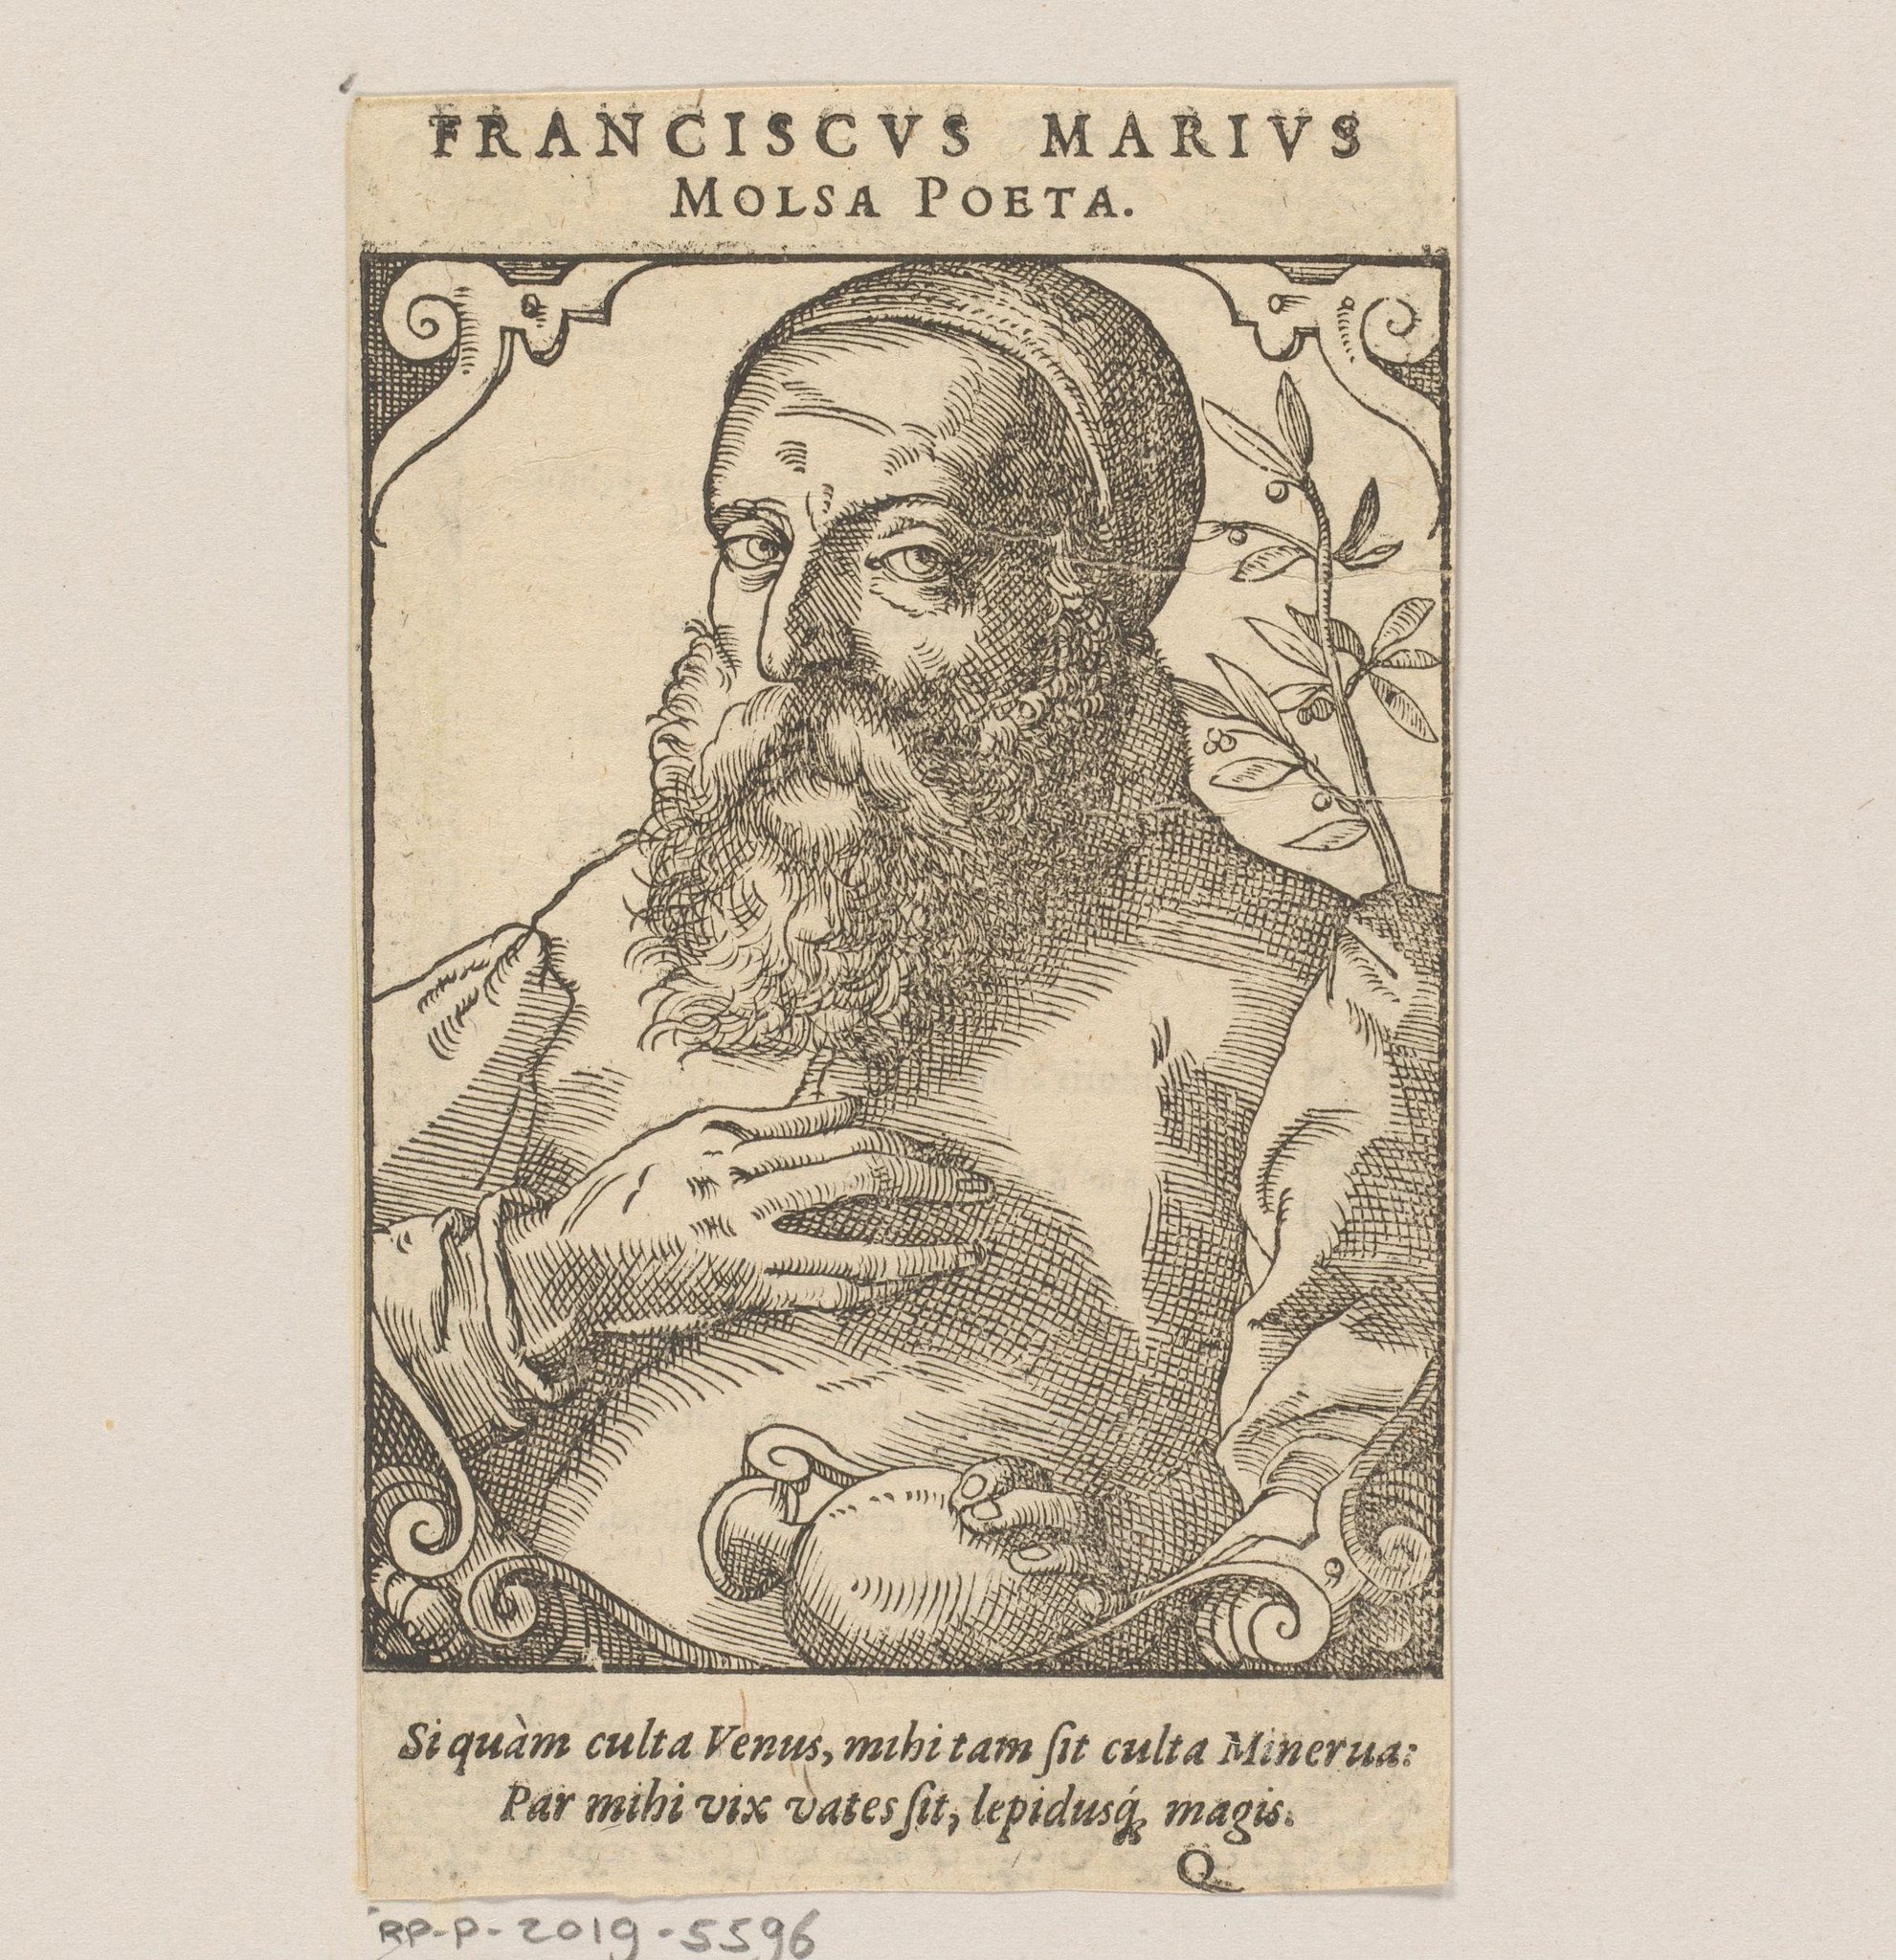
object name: print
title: Portret van Francesco Maria Molza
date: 1589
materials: paper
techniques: letterpress printing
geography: basel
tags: historical persons, writer, poet, author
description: Prent uit: Reusner, Nikolaus. Icones sive imagines vivae, literis cl. virorum, Italiae, Graeciae (...). Bazel: Konrad Waldkirch, 1589. Prent eerder verschenen in: Giovio, Paolo. Elogia virorum literis illustrium, quotquot (...). Bazel: Peter Perna, 1577. Prent ook gebruikt in latere publicaties.